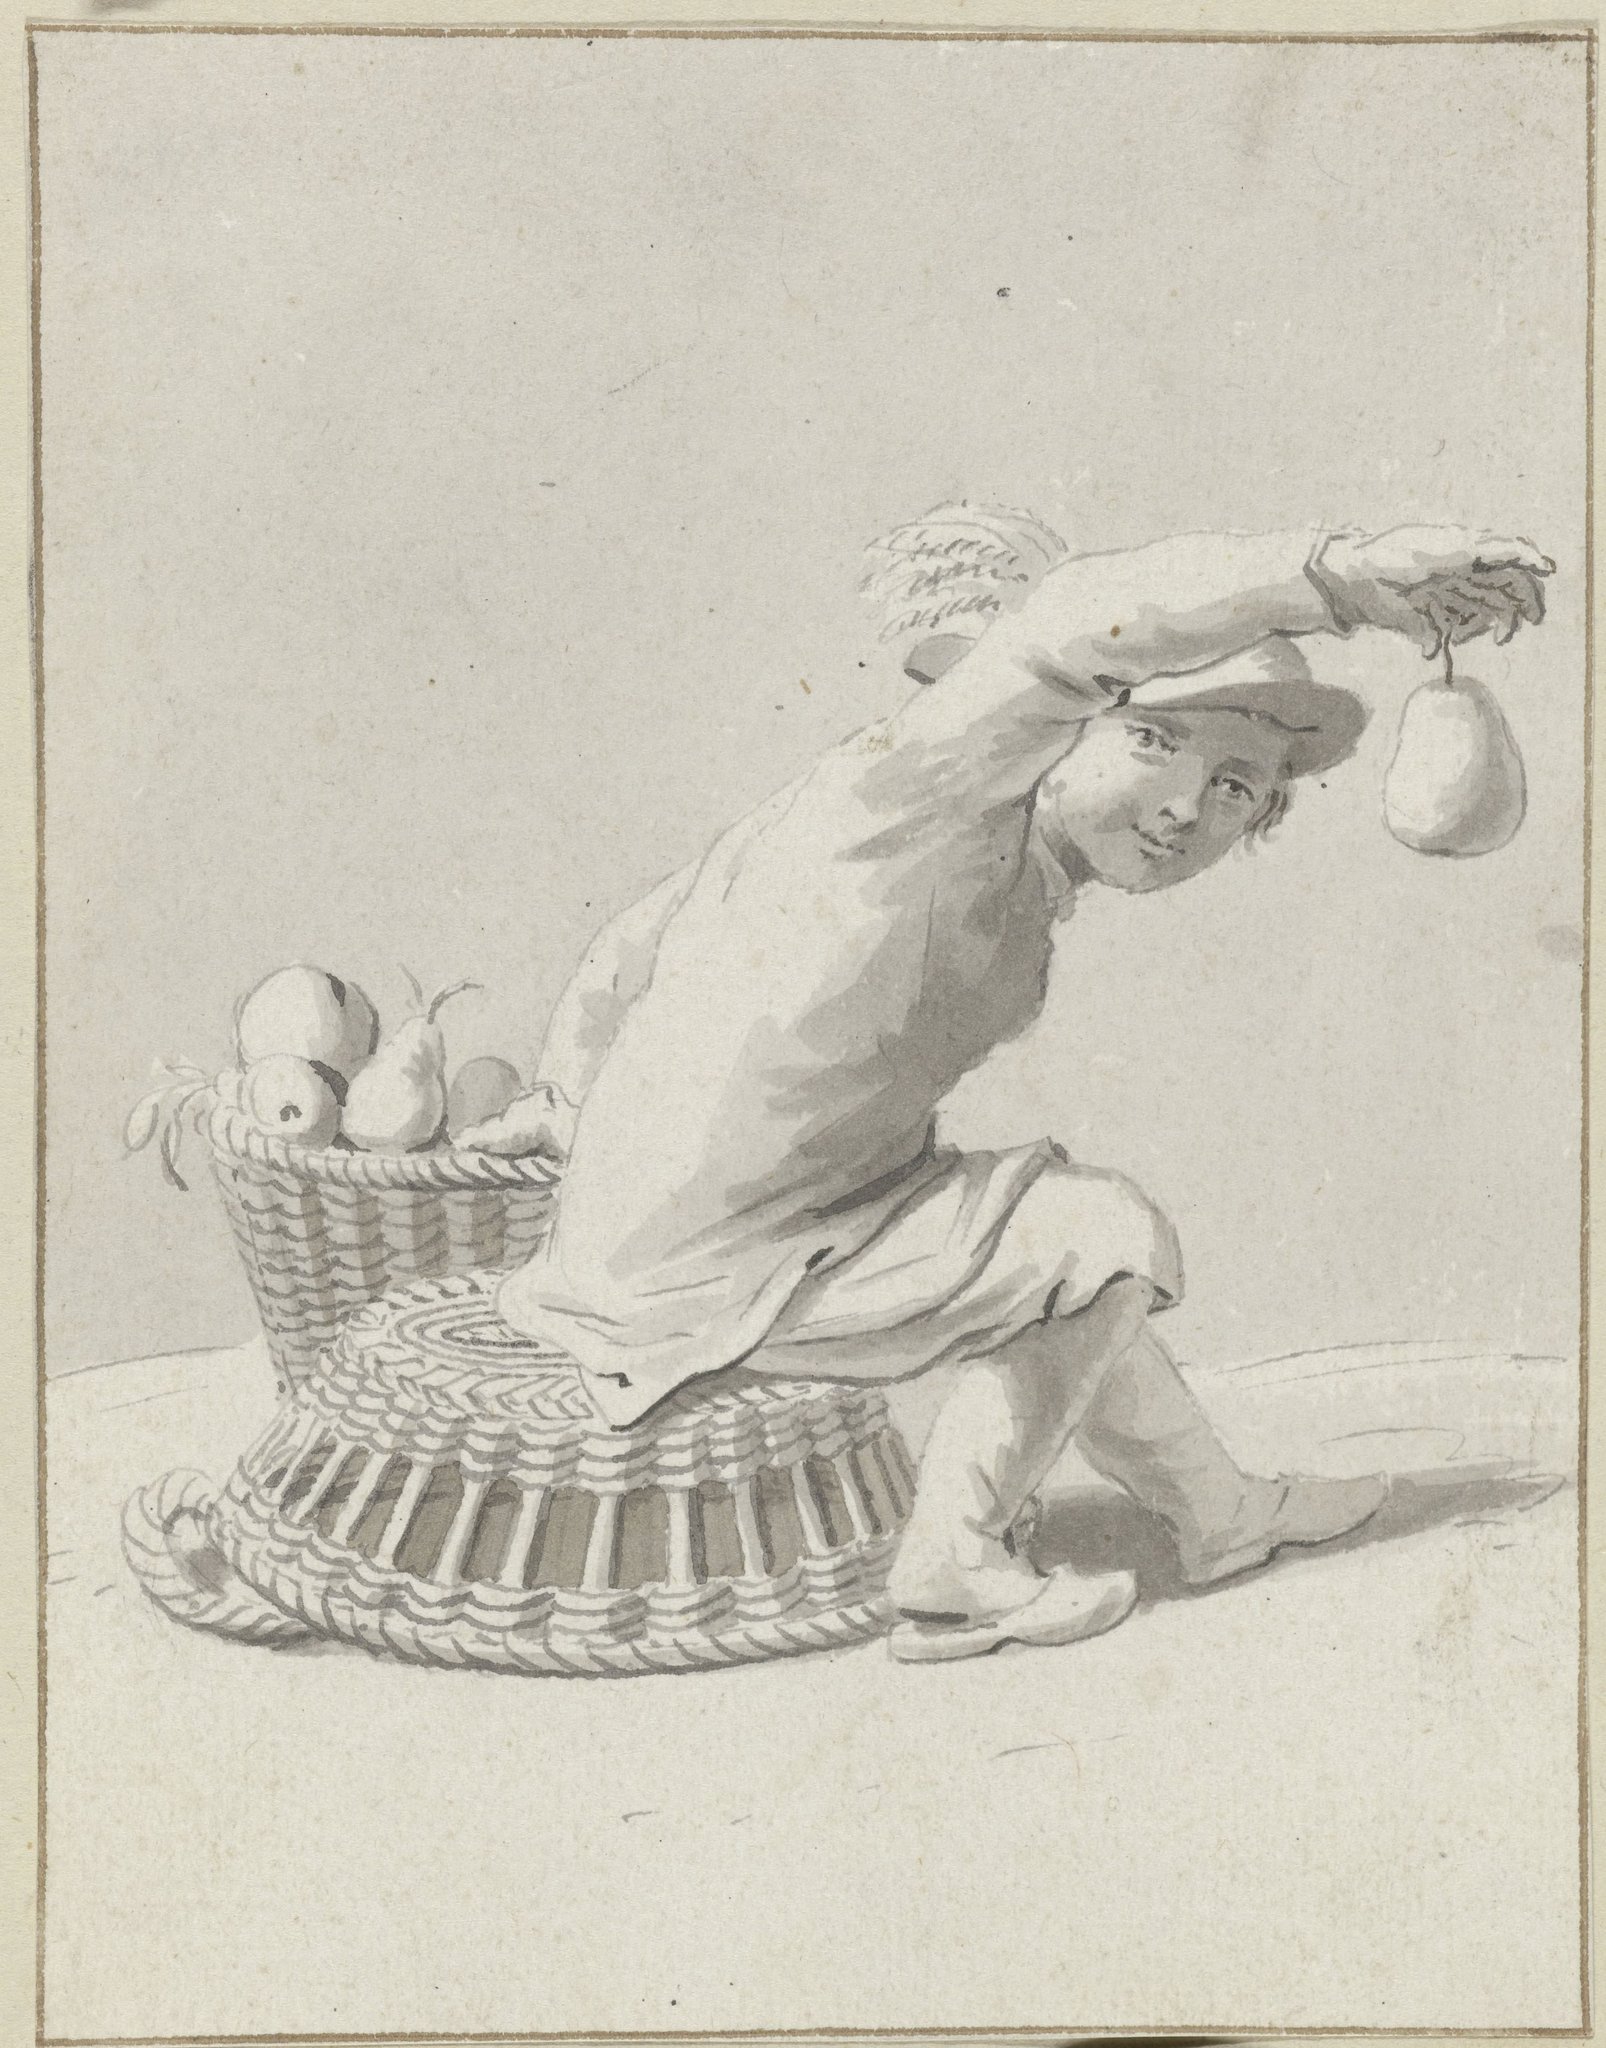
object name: drawing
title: Op een mand zittend kind met een peer in zijn hand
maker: Anonymous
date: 1700-1799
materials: ink, paper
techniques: brush, pen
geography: netherlands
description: Naast het kind staat een tweede mand met fruit.